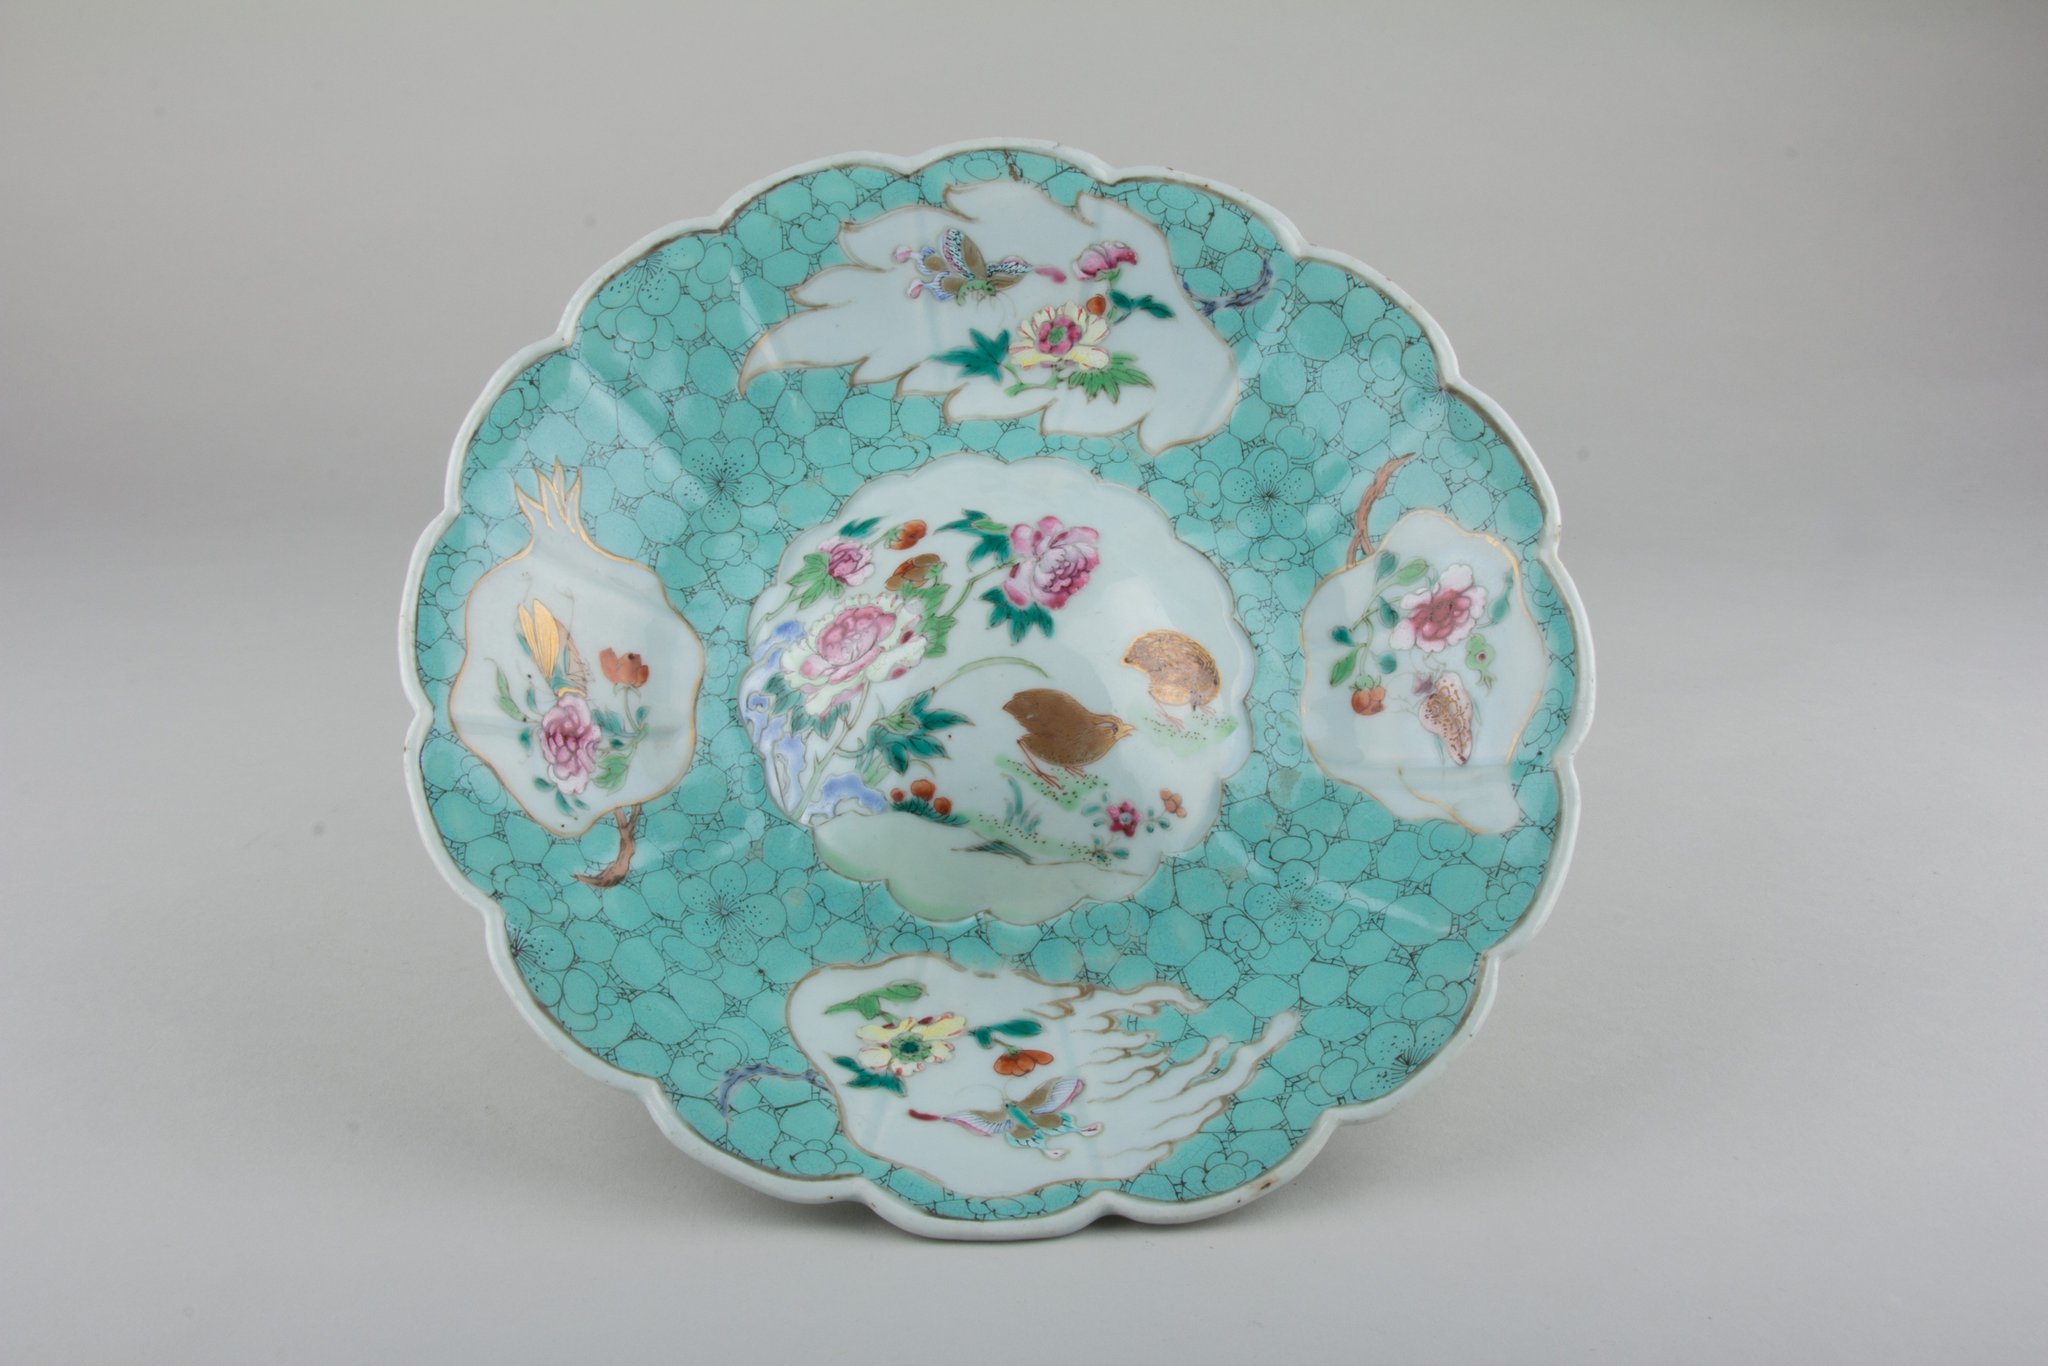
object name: dish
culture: chinese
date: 1701-1800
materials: enamel, porcelain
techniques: overglaze, painting, polychrome, underglaze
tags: birds